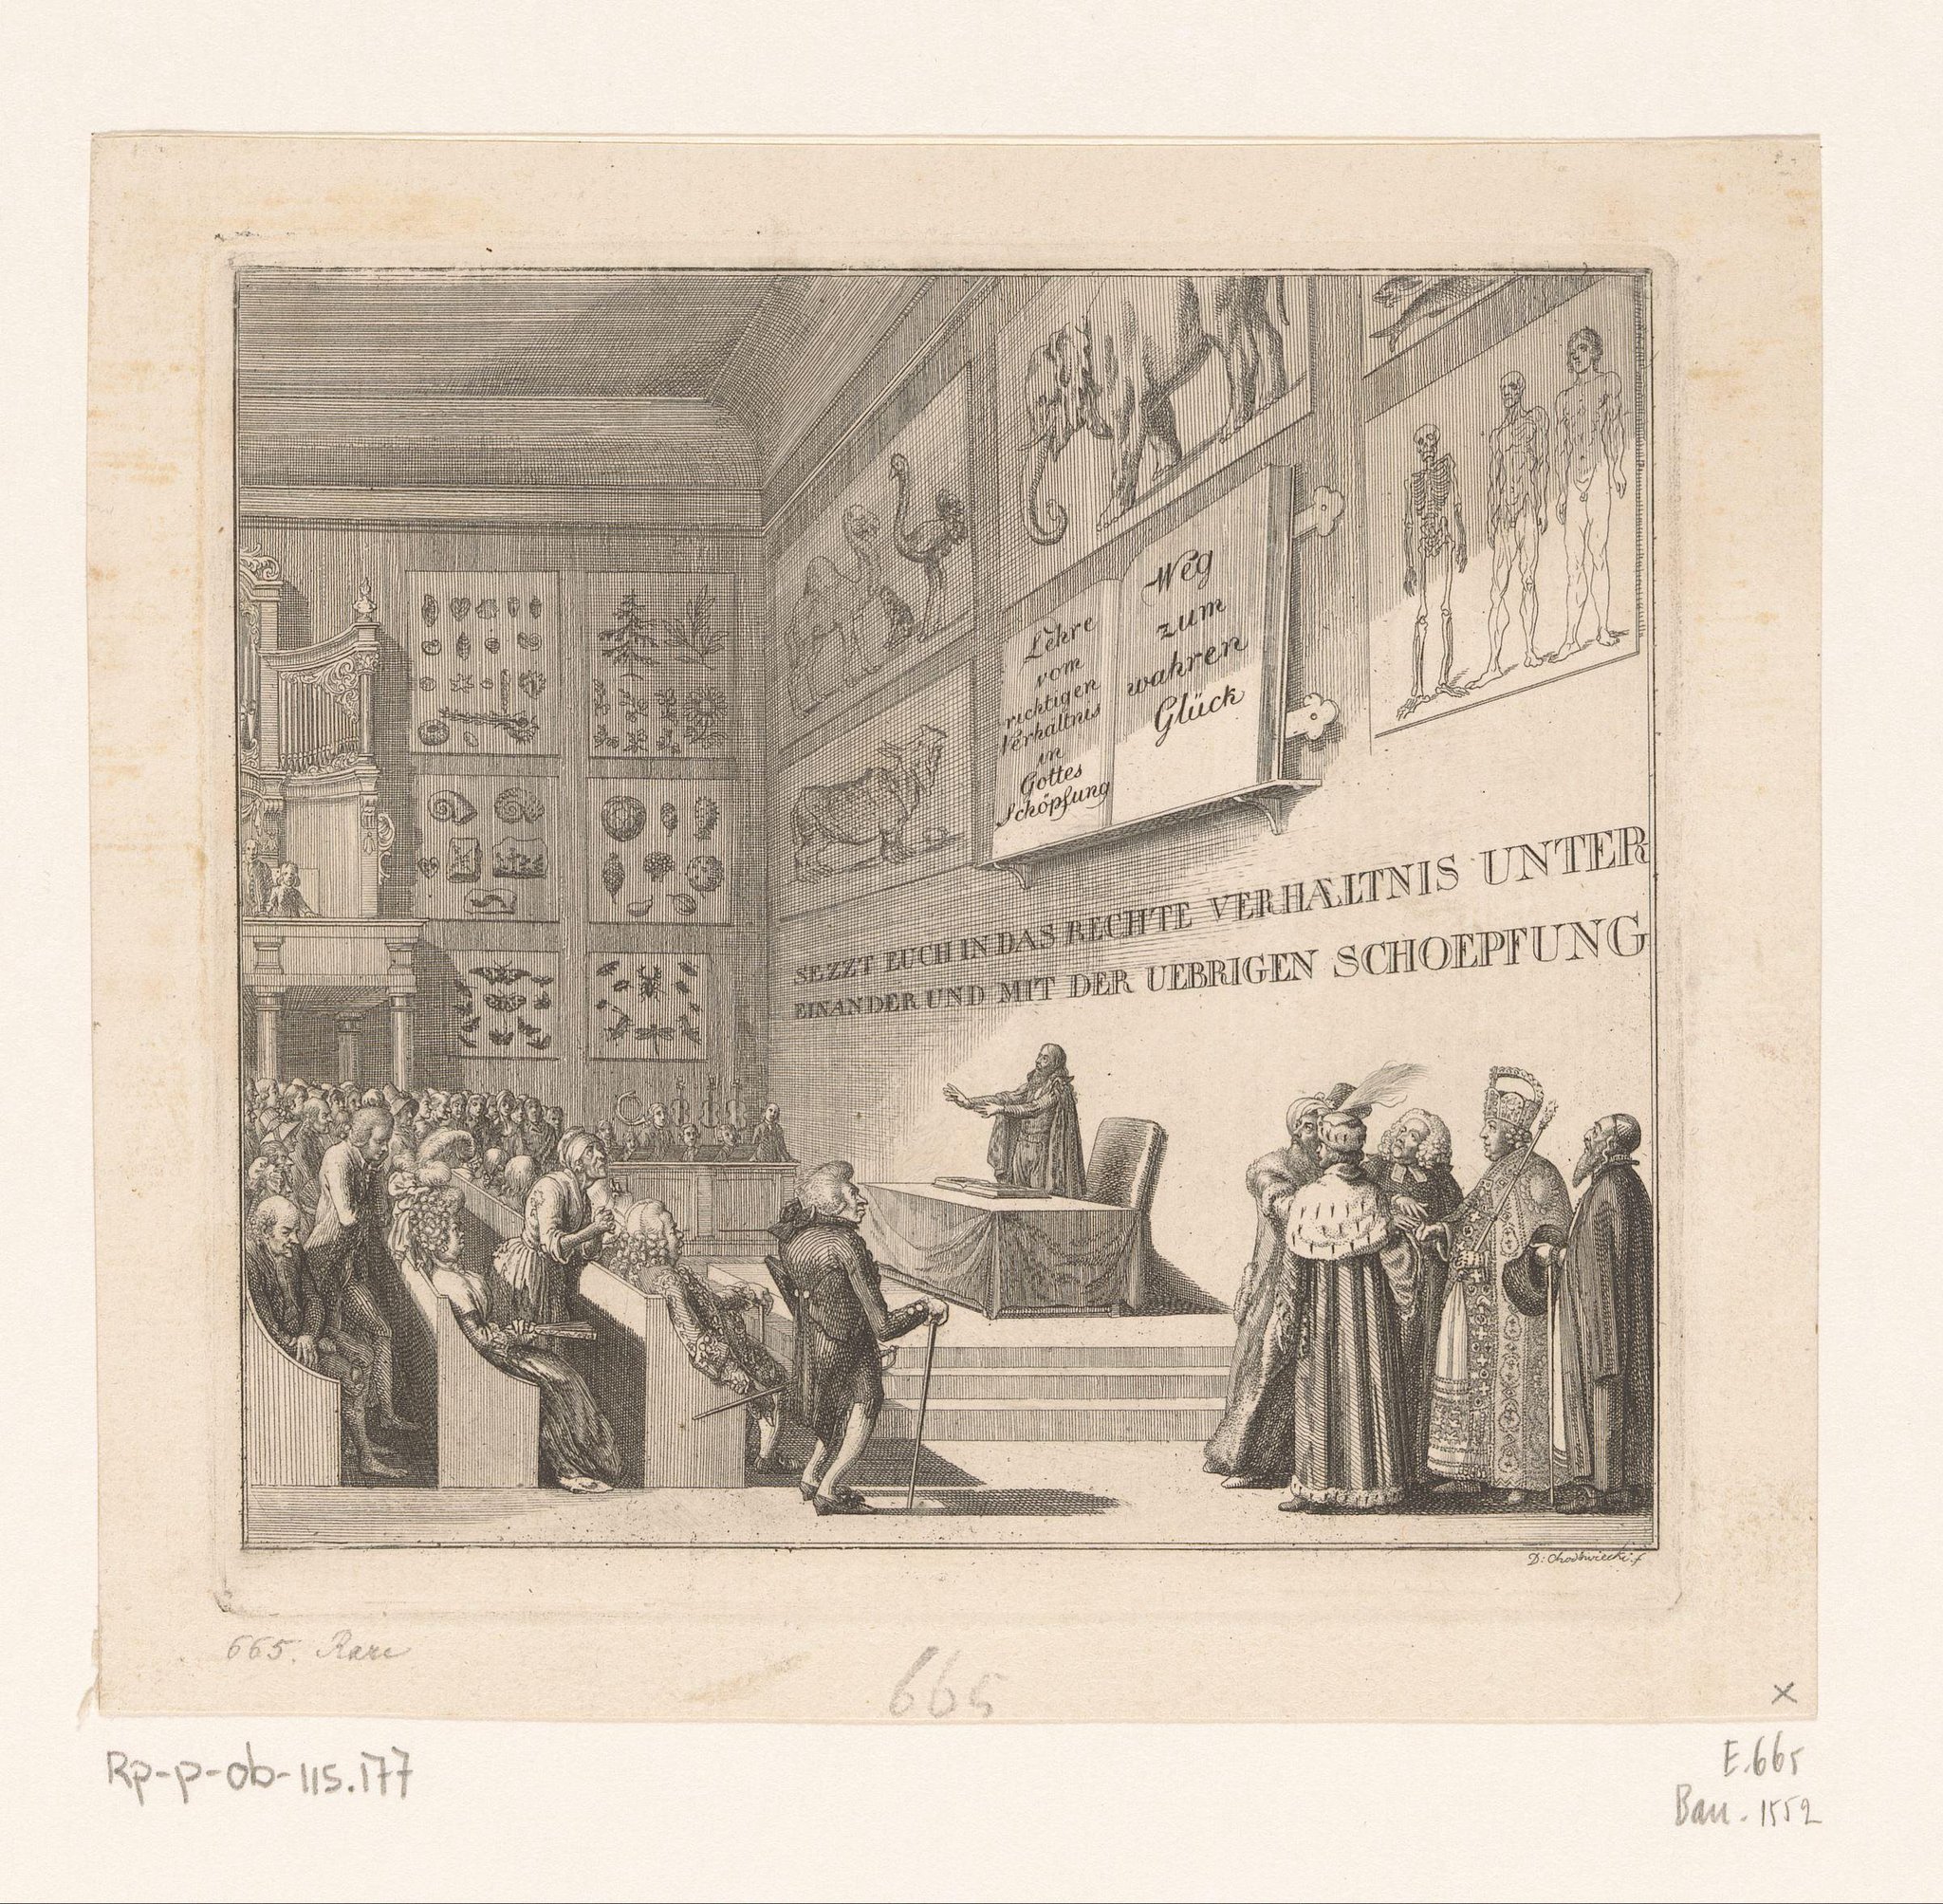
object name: print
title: Allegorie op de wereld en samenleving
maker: daniel nikolaus chodowiecki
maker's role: draughtsman, print maker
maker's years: 1726-1801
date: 1791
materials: paper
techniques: etching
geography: berlin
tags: plants; vegetation, animals, music, anatomy (non-medical), society, civilization, culture, utopia, book - mm - book open, philosophy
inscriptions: collector's mark: Lugt 2228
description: Prent gebruikt voor: Ziegenhagen, Franz Heirnich. Lehre von dem richtigen Verhältnis zu den Schöpfungswerken, und durch öffentliche Einfürung derselben allein bewürkende algemeine Menschbeglükkung (...). Hamburg: s.n., 1792.